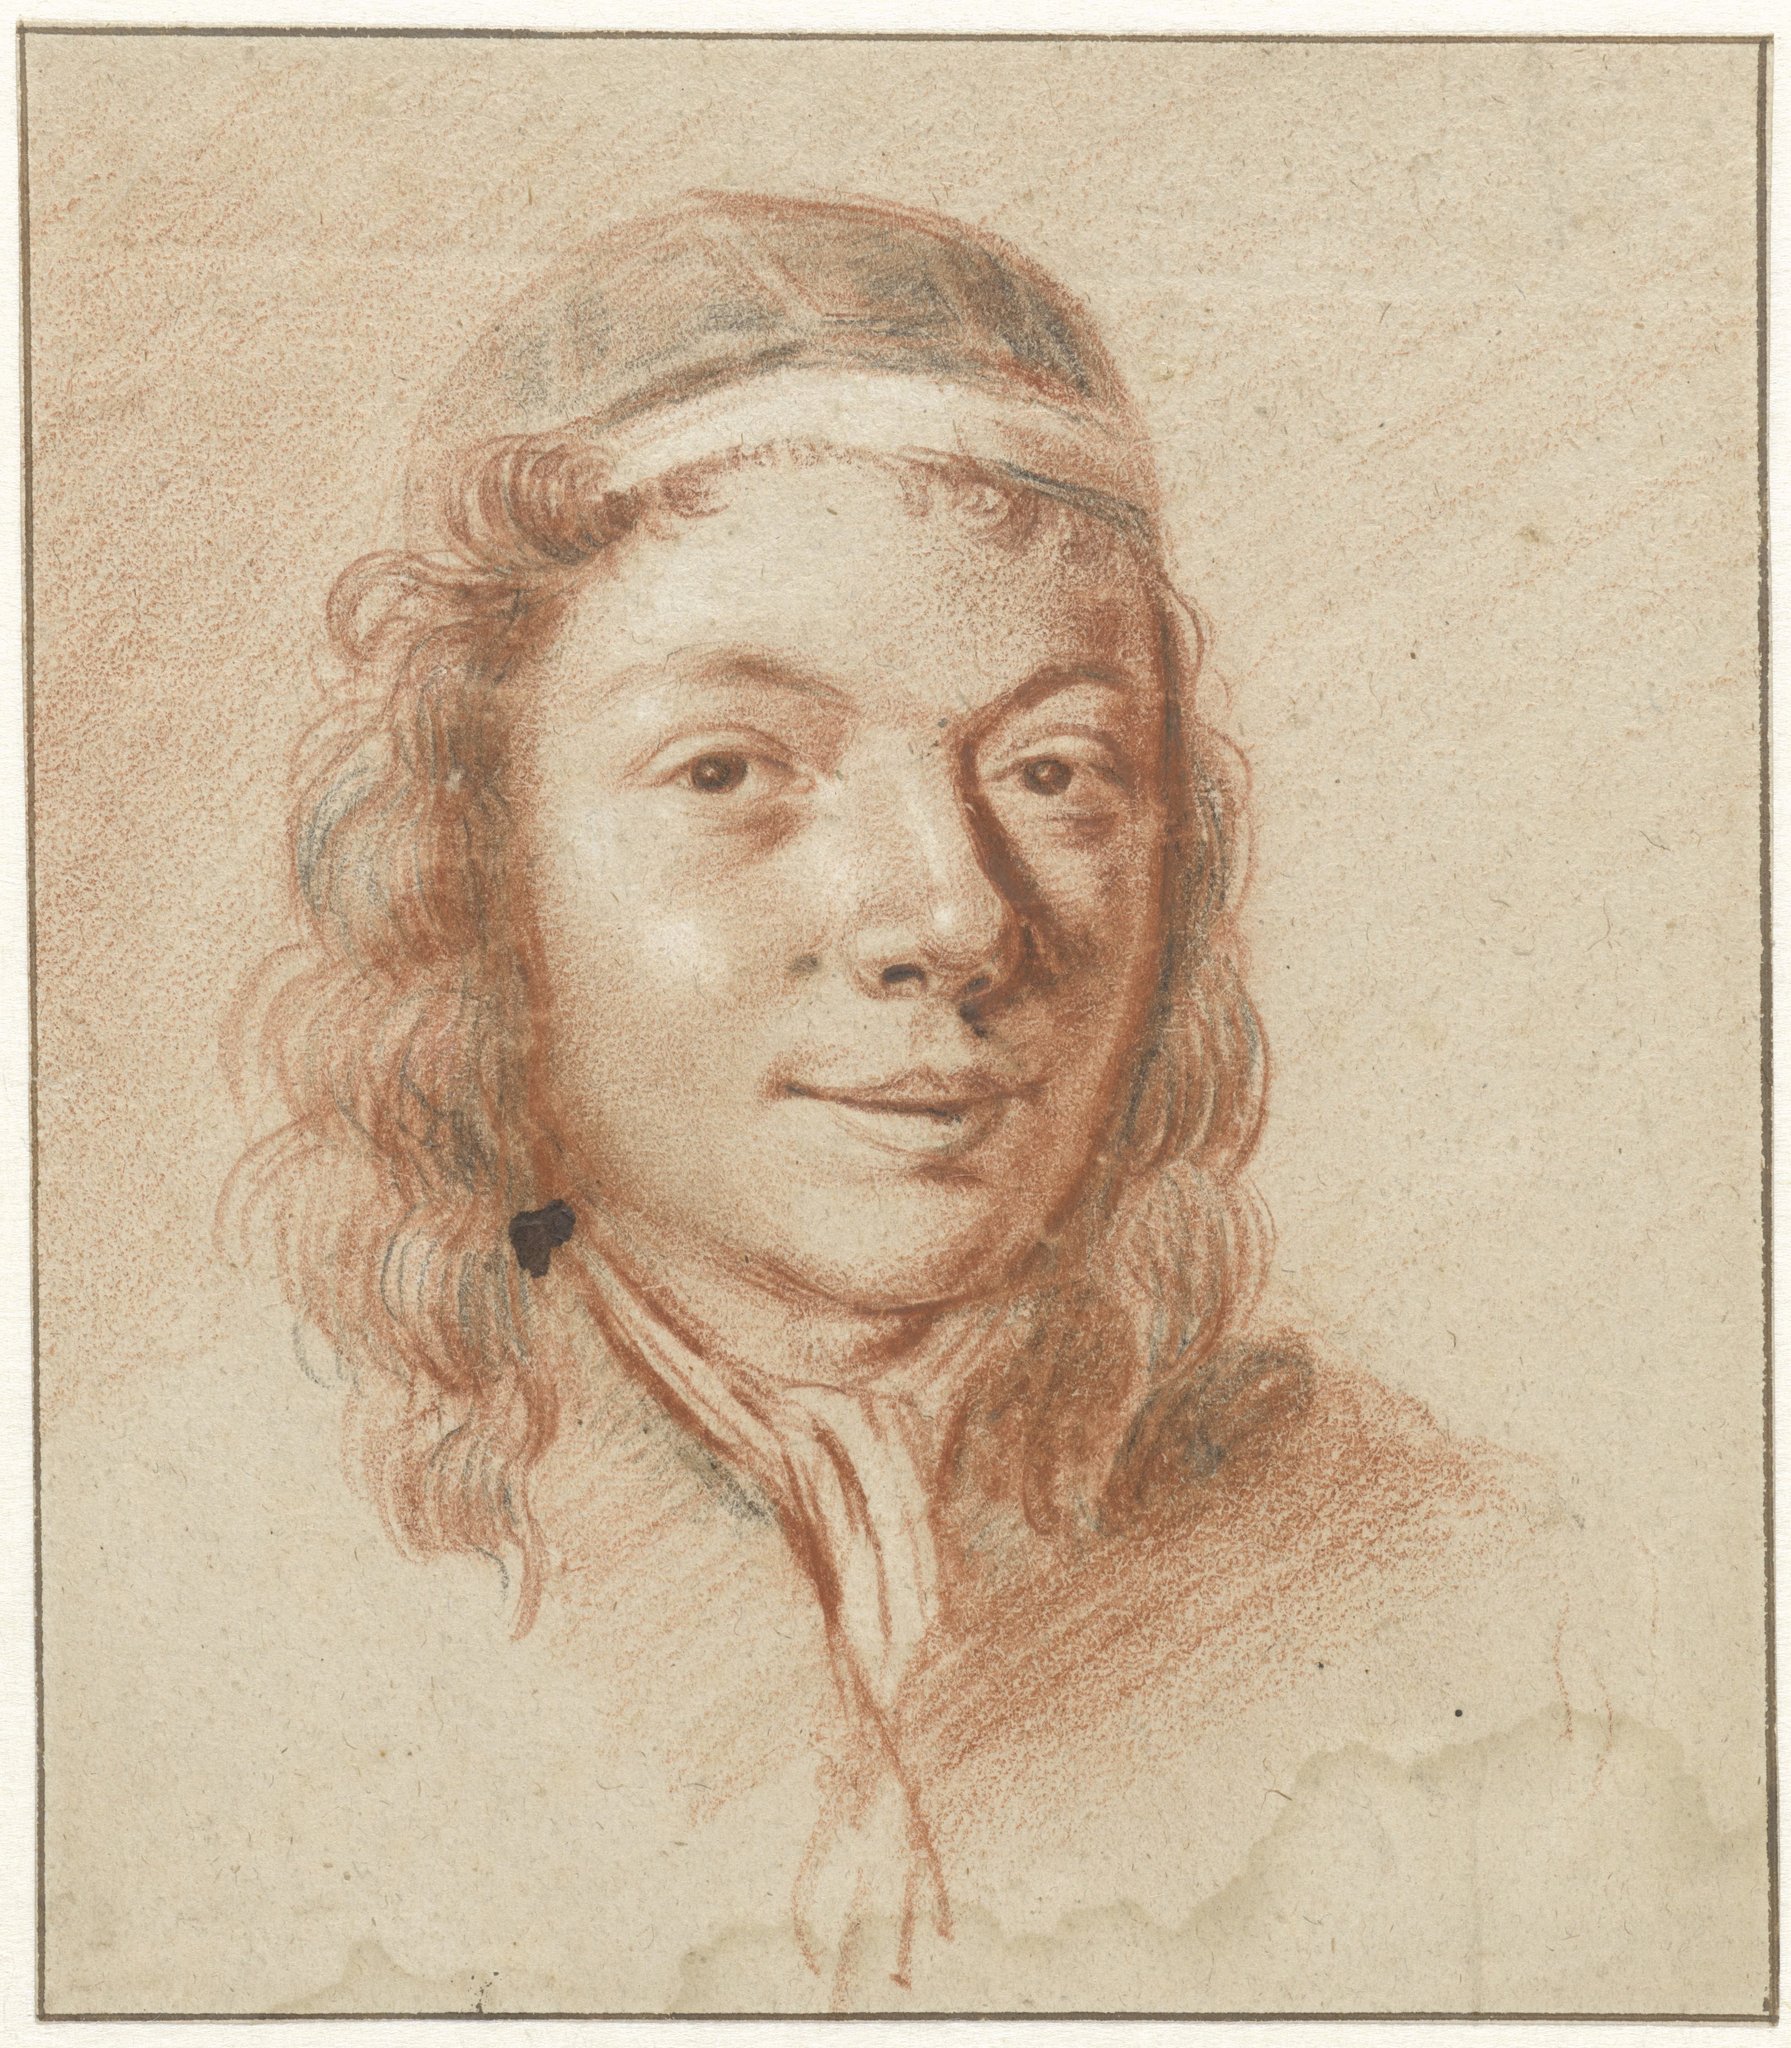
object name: drawing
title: Portret van een jongeman, in driekwart naar rechts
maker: Anonymous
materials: chalk, paper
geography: netherlands